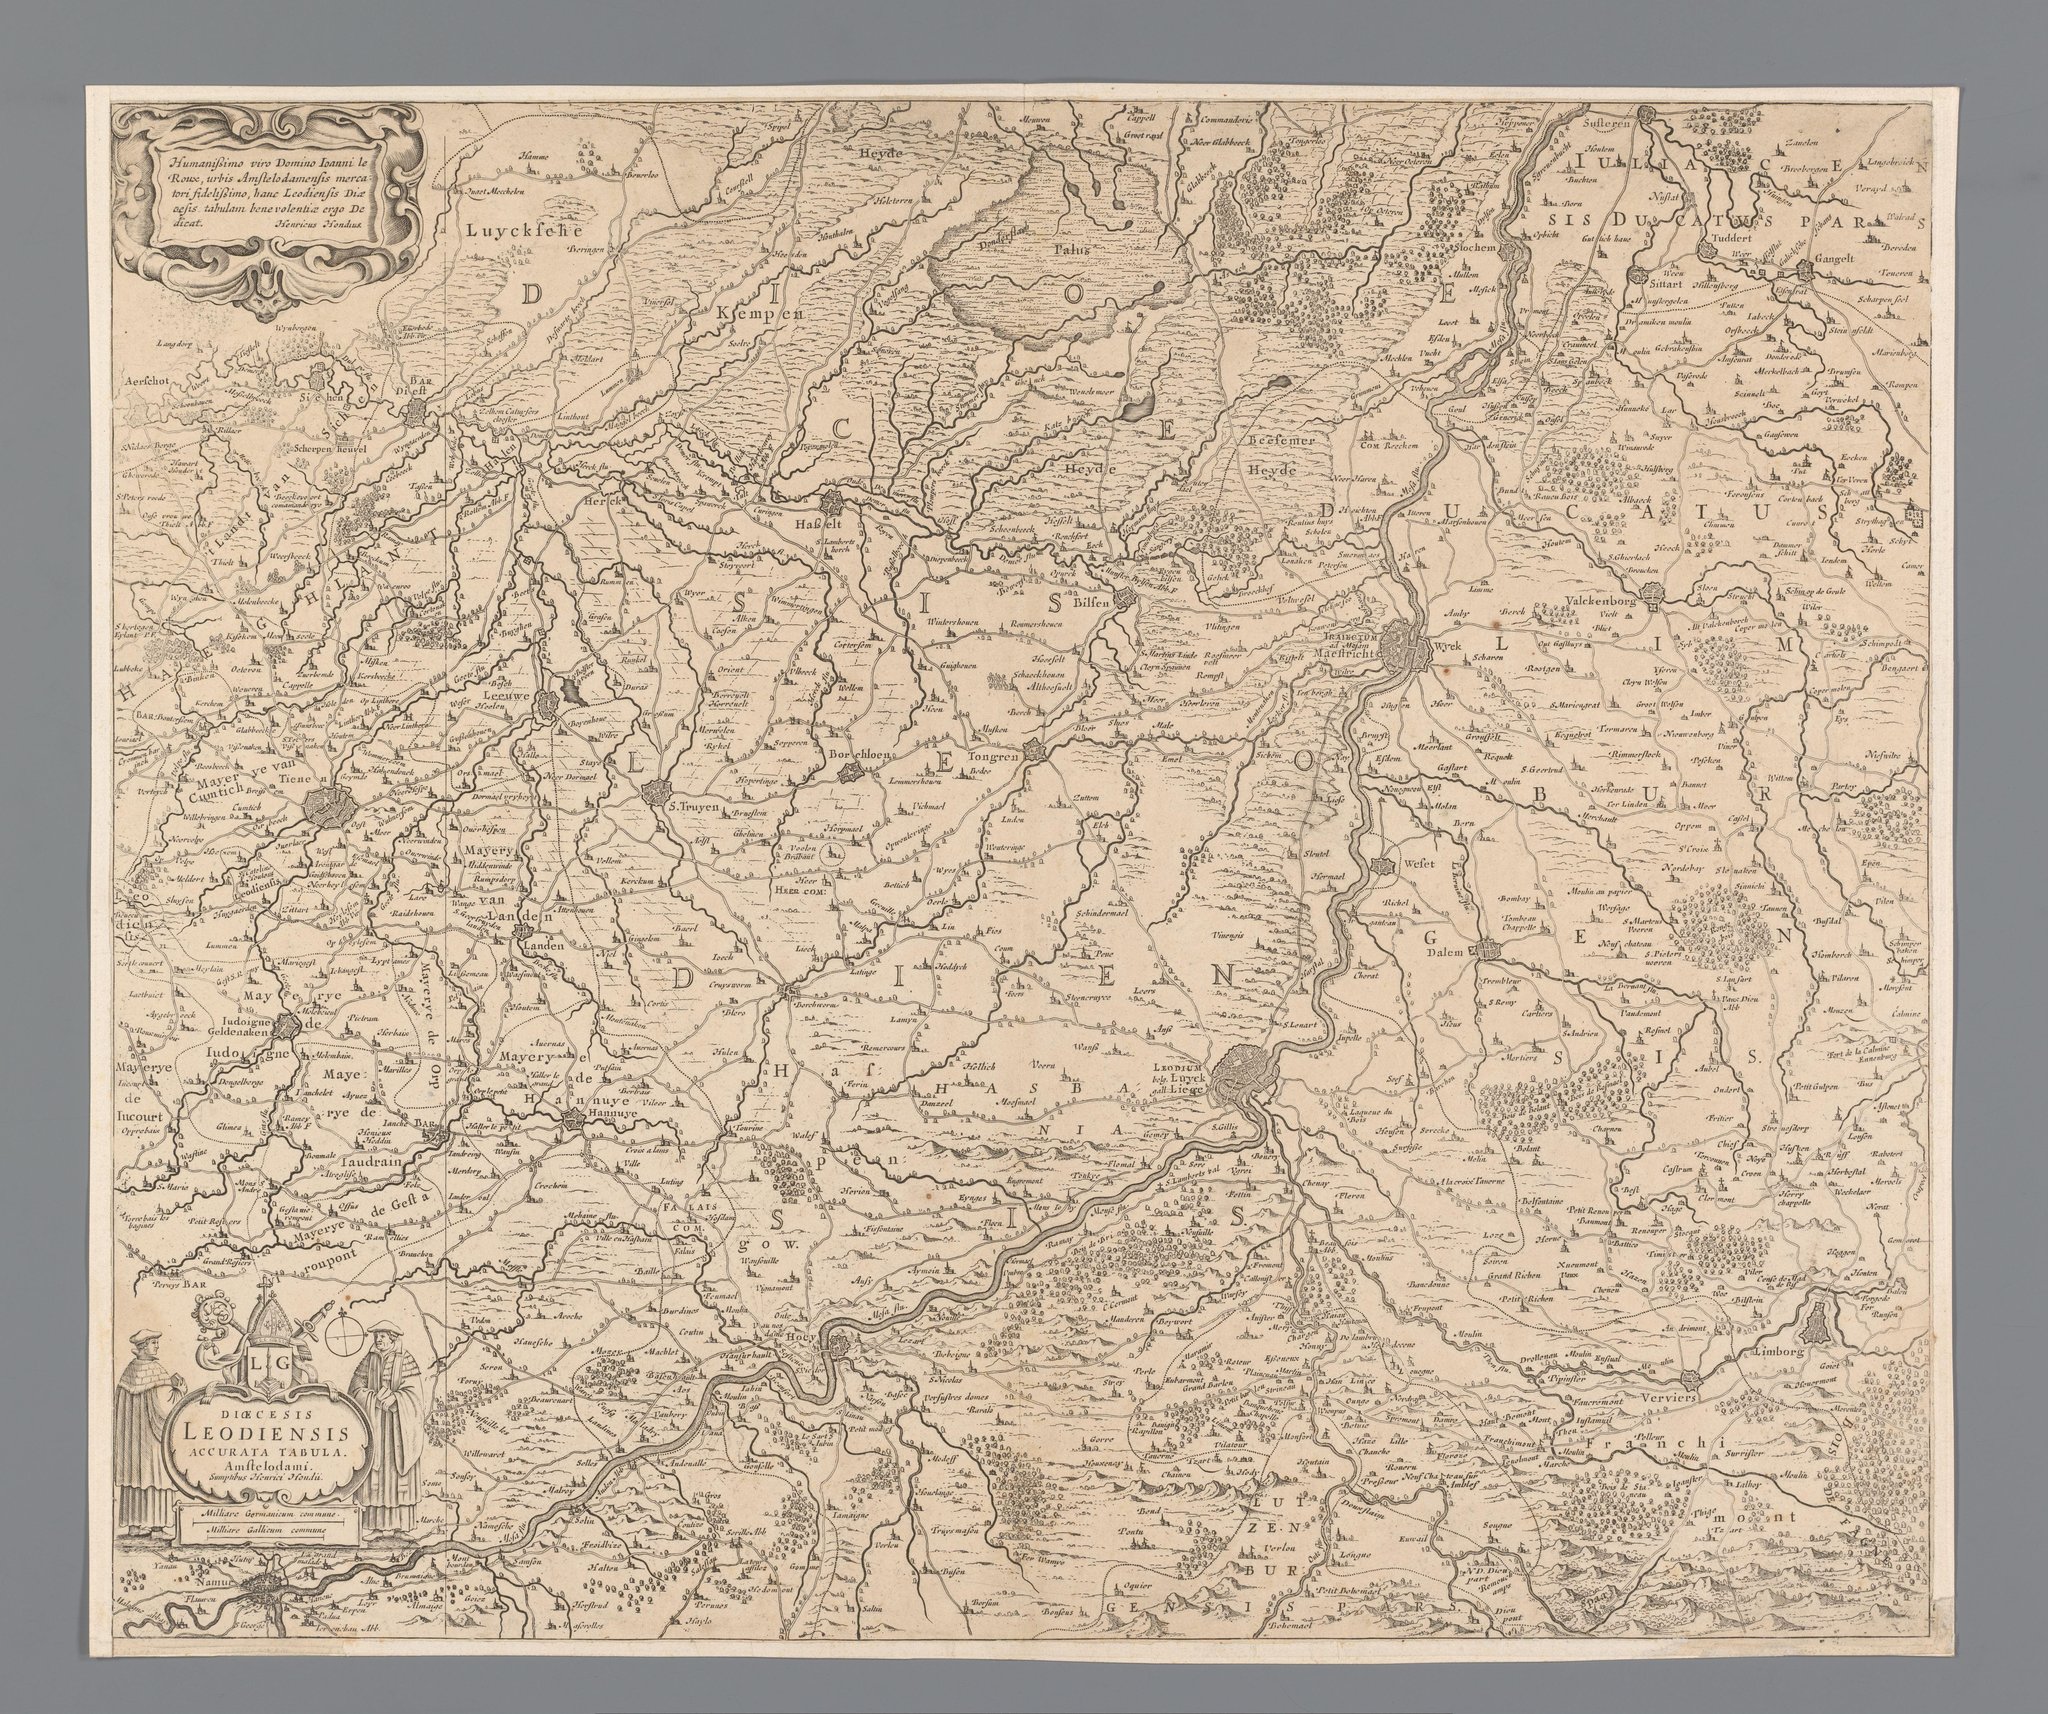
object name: print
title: Kaart van het prinsbisdom Luik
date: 1633-1649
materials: paper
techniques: etching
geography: amsterdam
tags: maps of separate countries or regions, prince-bishopric of liège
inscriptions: collector's mark: Lugt 2228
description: Prent onder andere gebruikt in: Mercator, Gerard, en Jodocus Hondius. Atlas ou representation du monde universel, et des parties d’icelui (…). 2 dln. Amsterdam: Henricus Hondius, 1633.